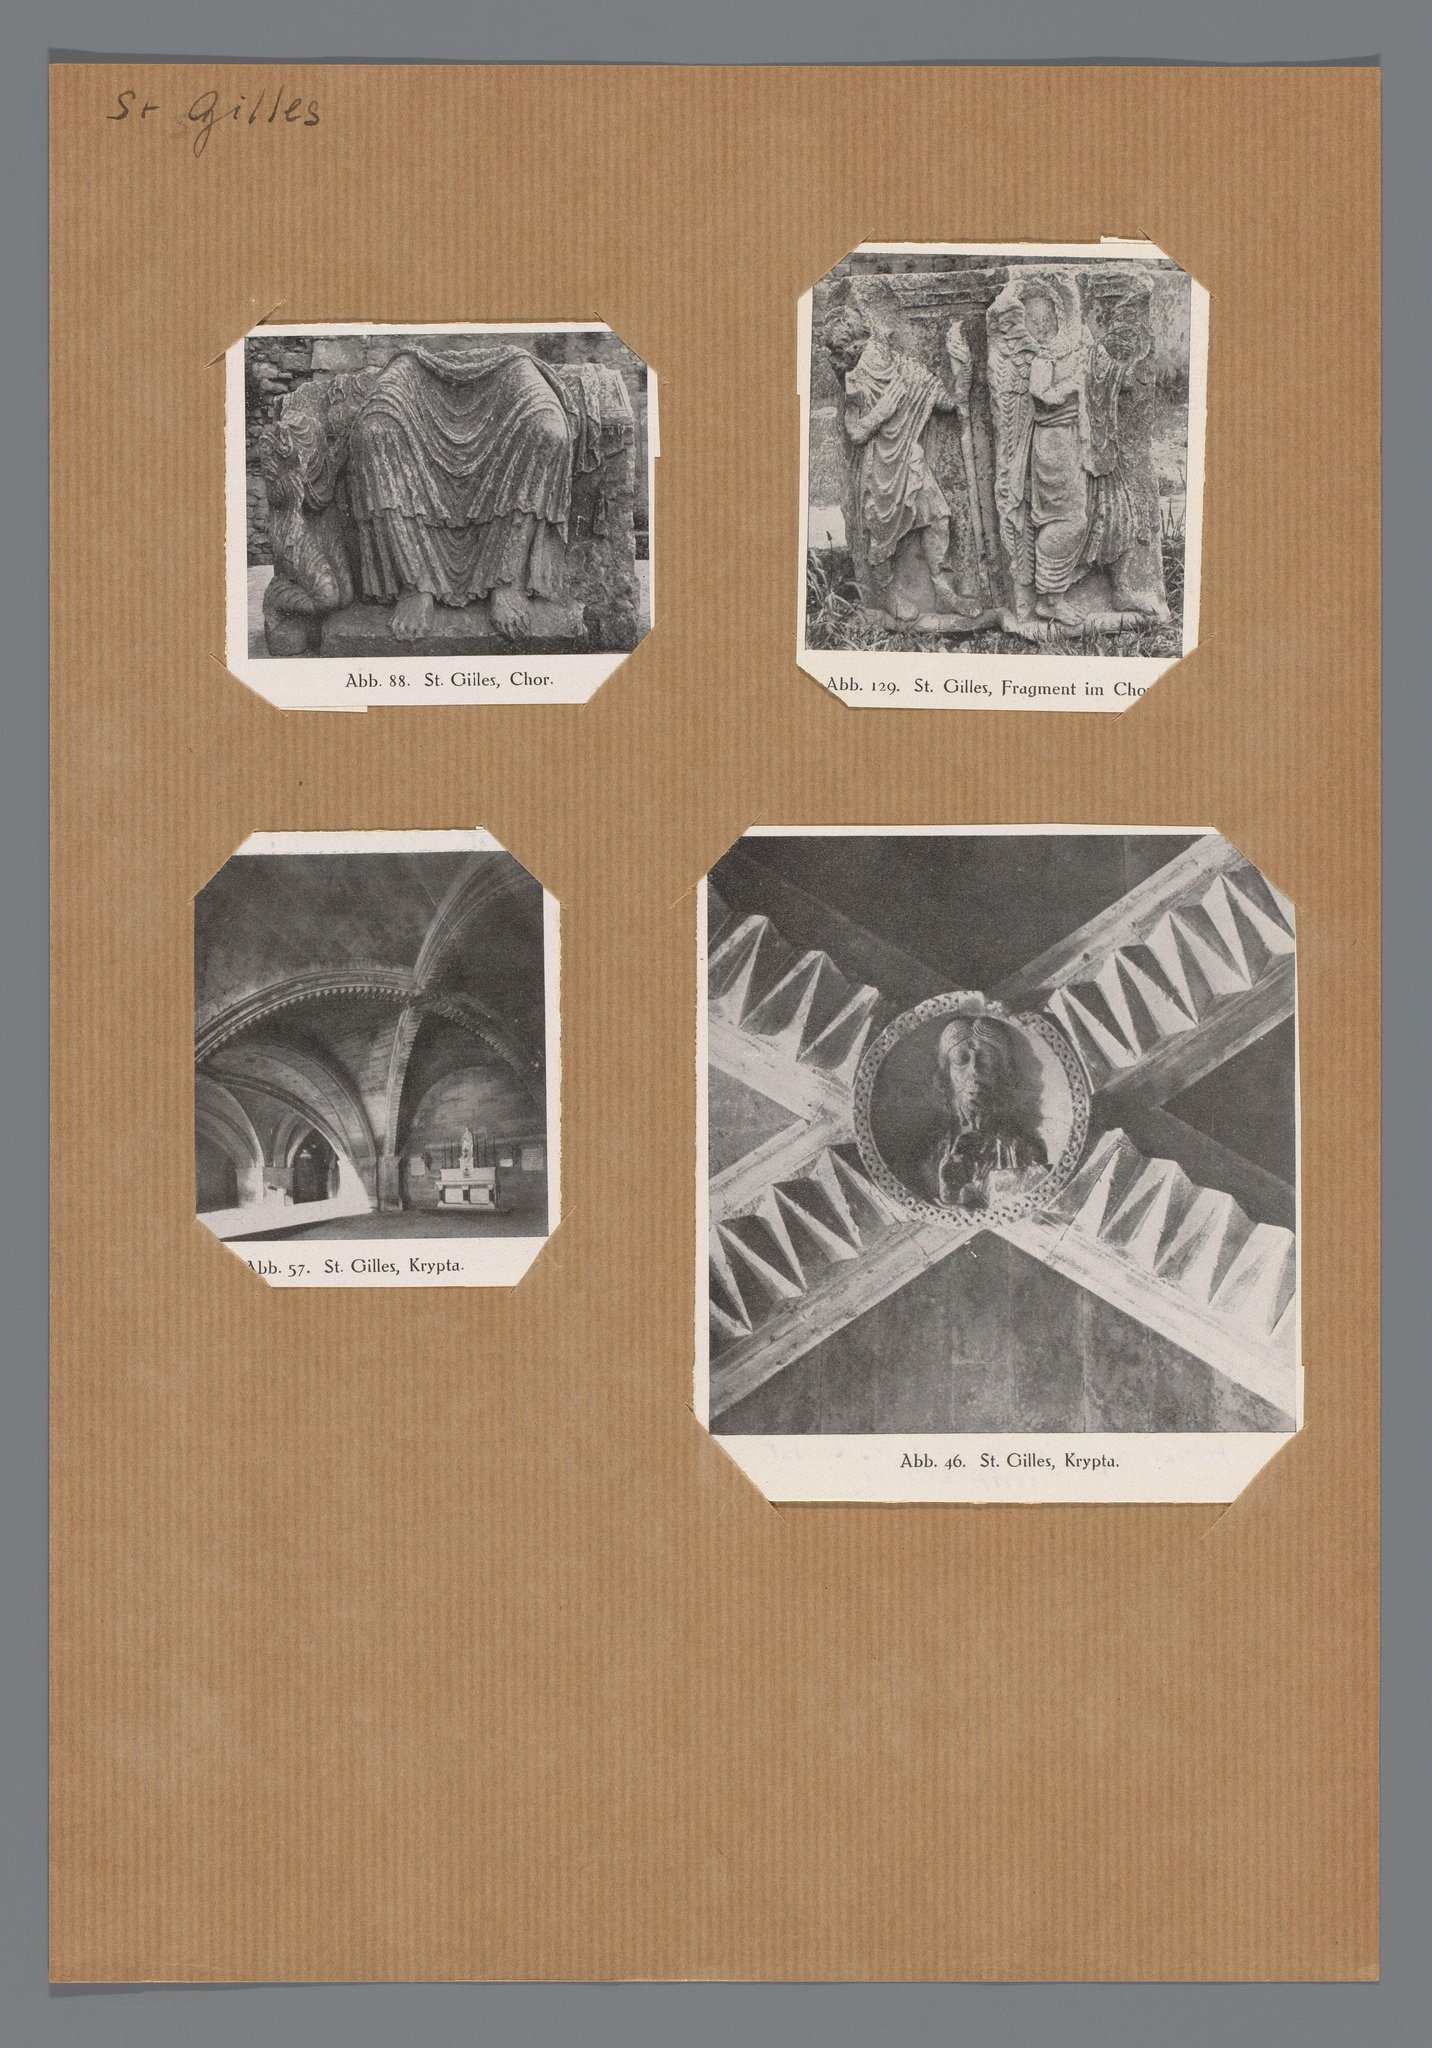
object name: photograph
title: Saint-Gilles, Kirche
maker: Anonymous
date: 1900-1950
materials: paper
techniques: photograph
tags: france